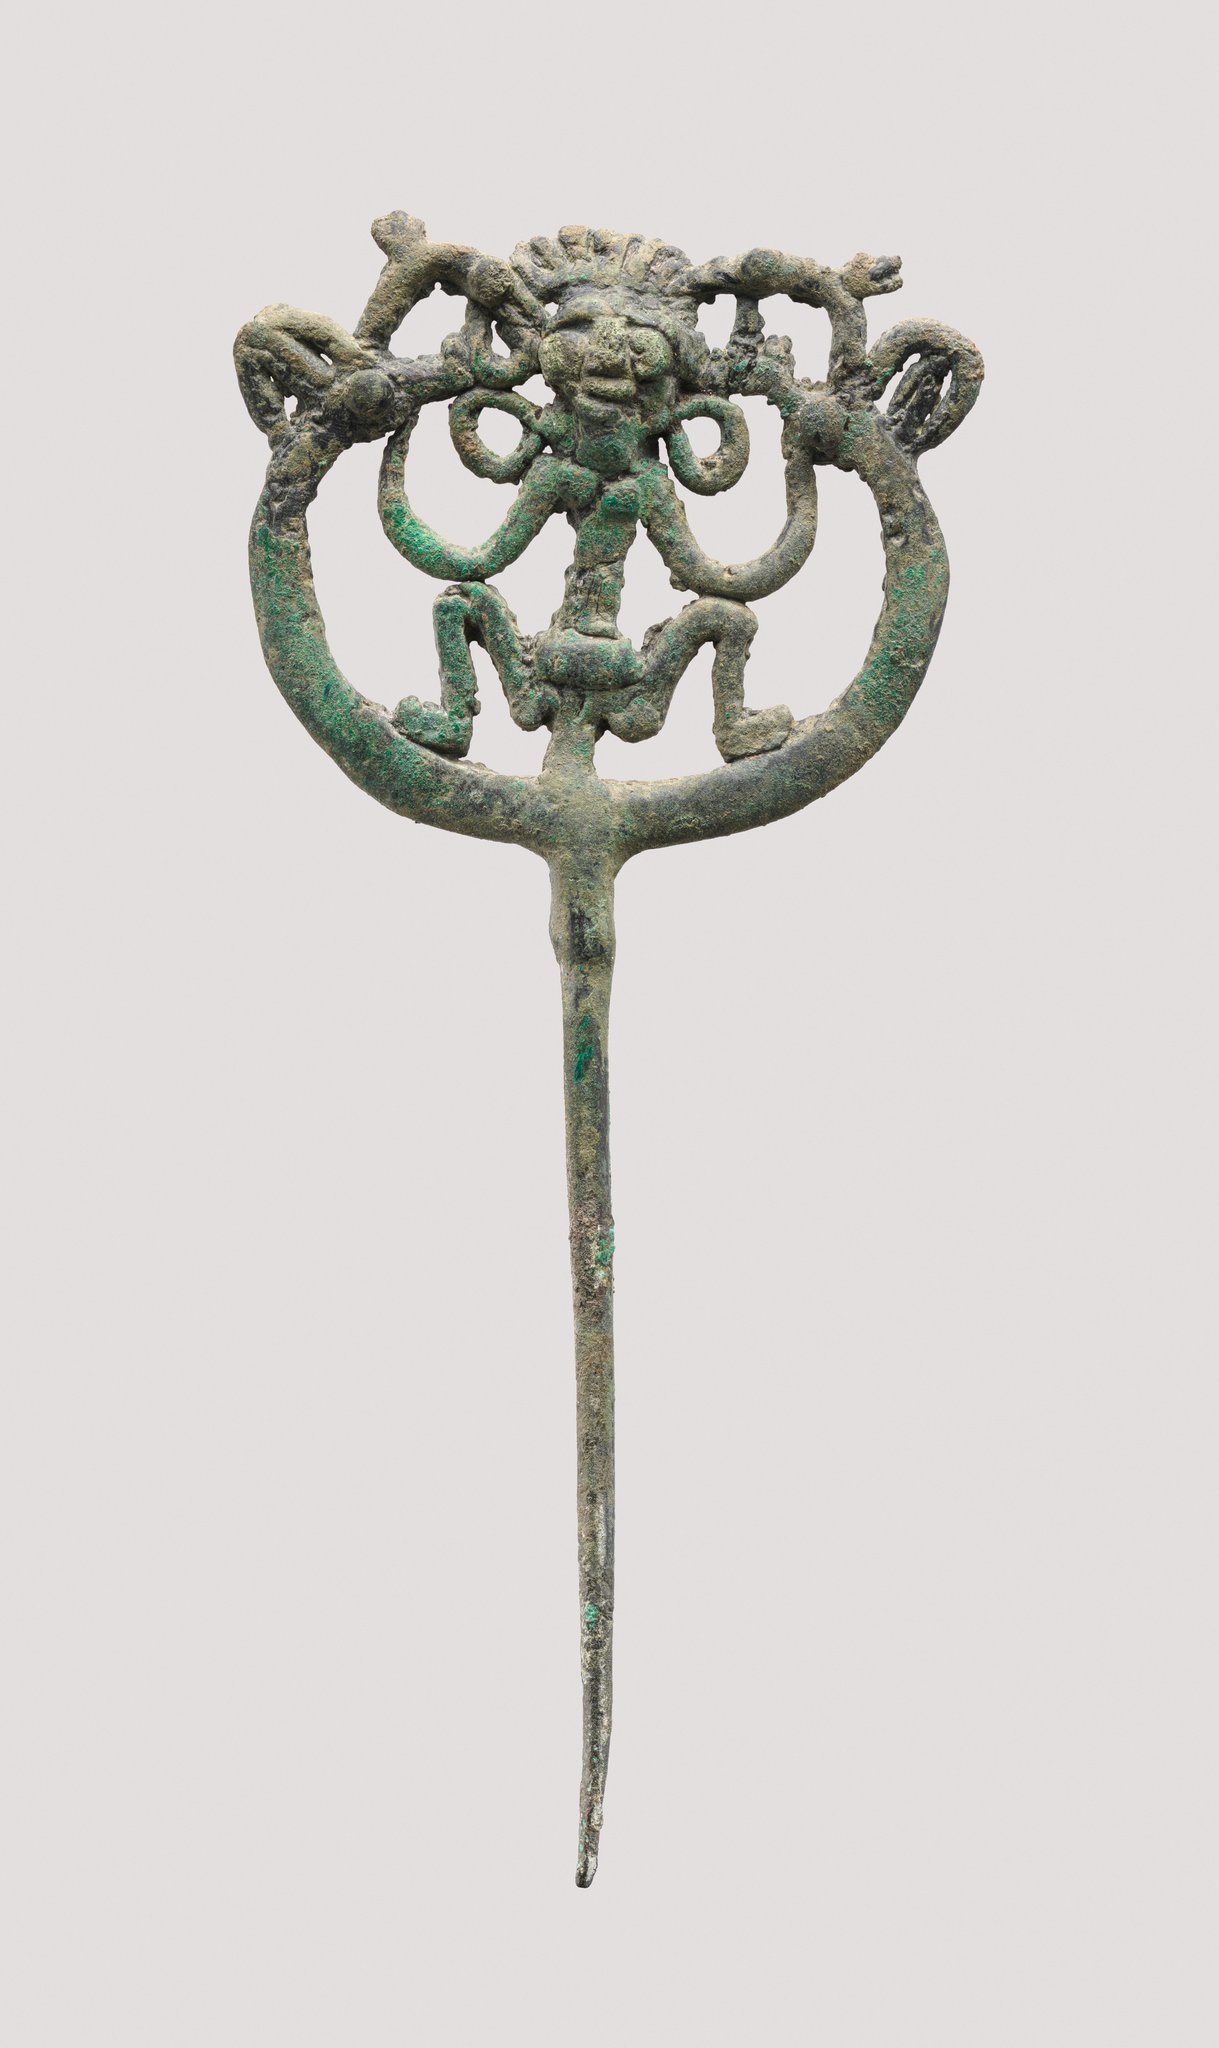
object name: pin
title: Openwork pin with a squatting female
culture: iranian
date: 800-601 BCE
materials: bronze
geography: iran, luristan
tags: women